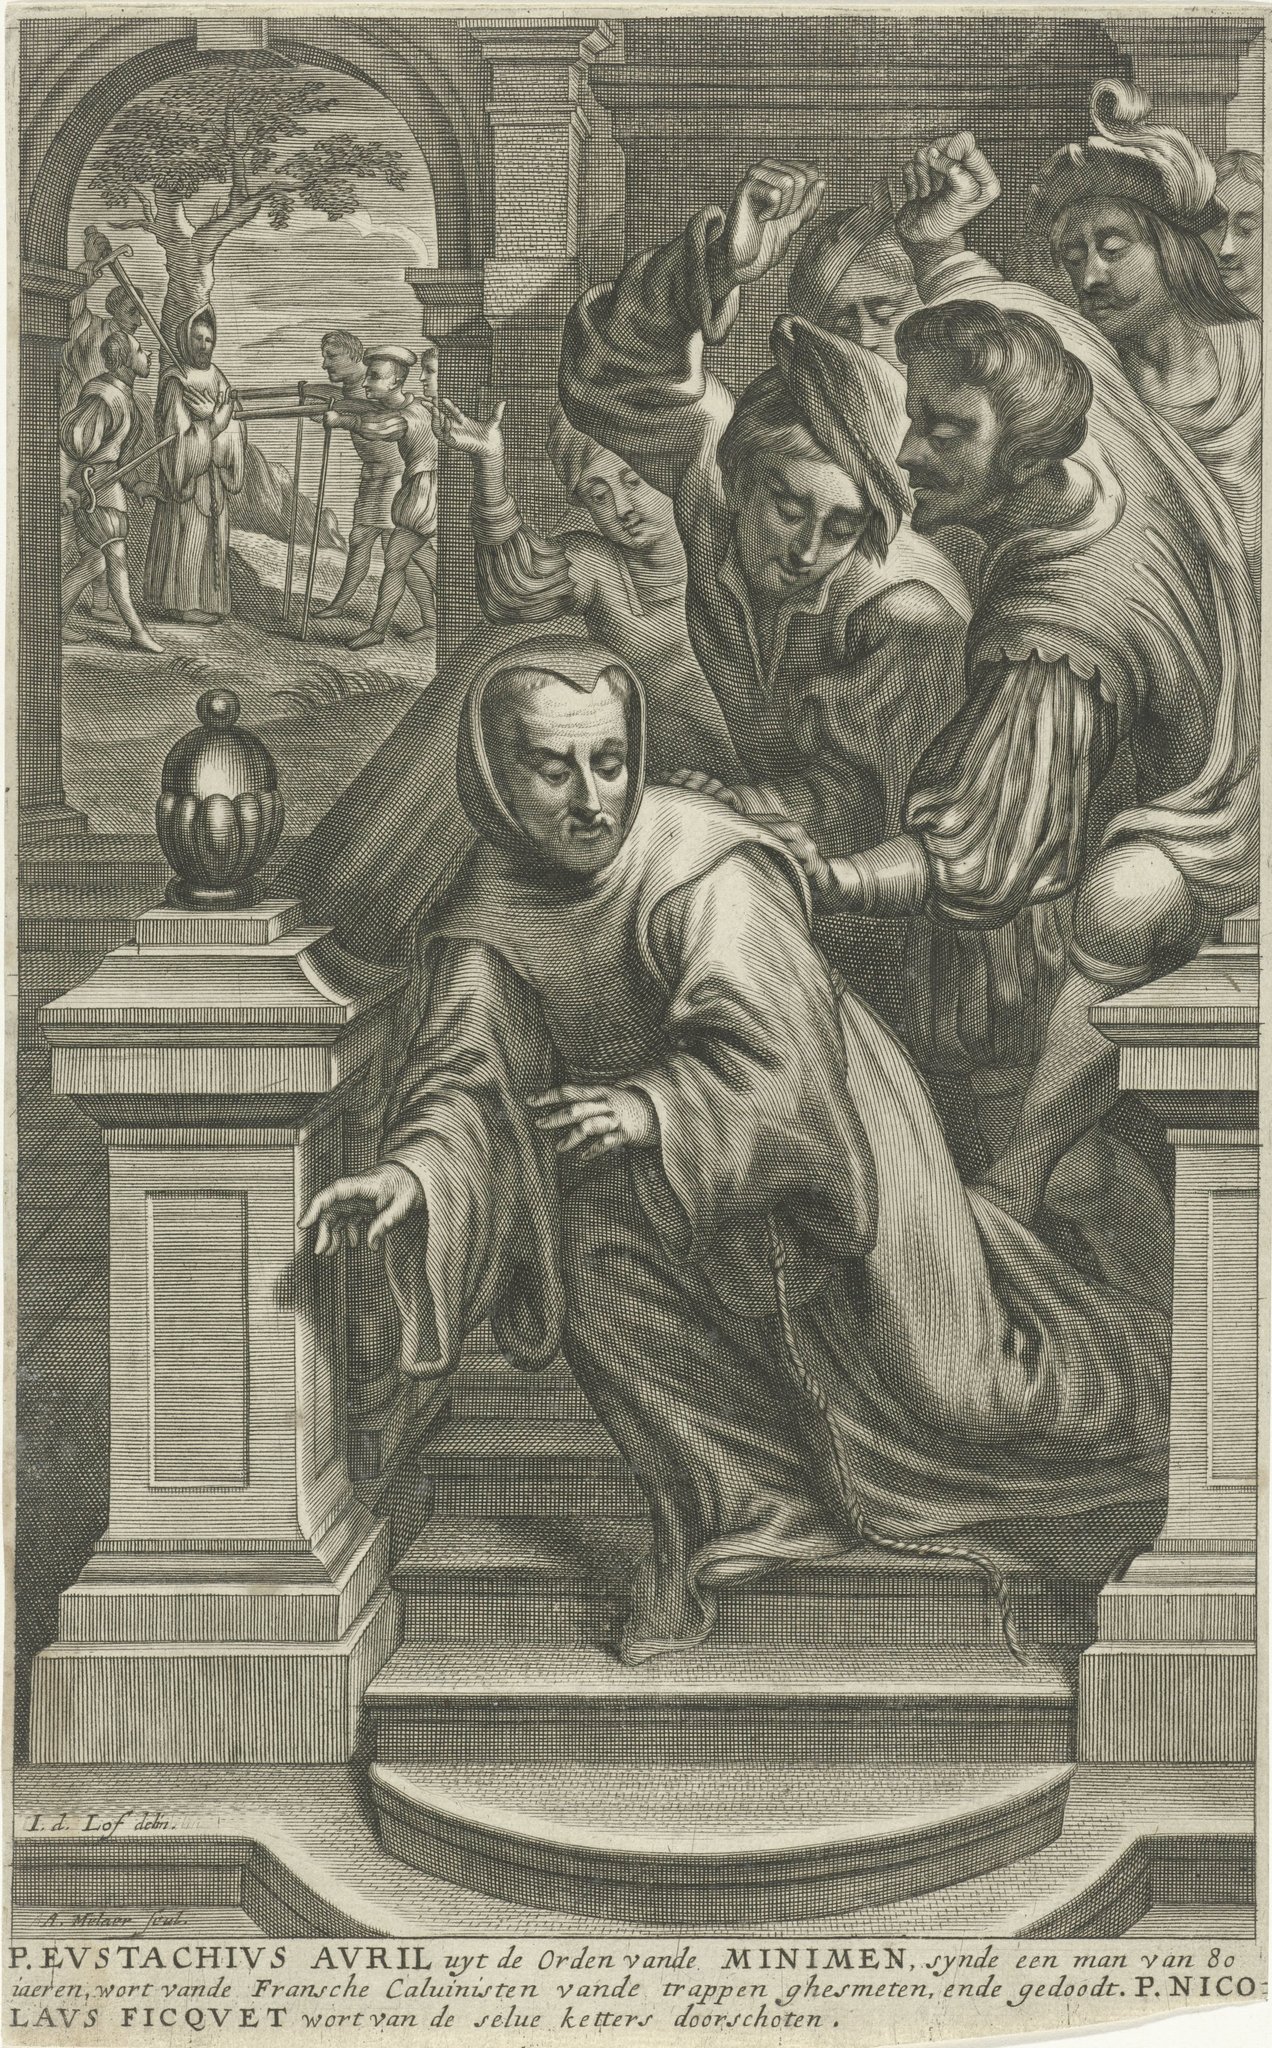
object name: print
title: Eustachius Avril door calvinisten van de trap geworpen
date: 1645-1668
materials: paper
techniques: engraving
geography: antwerp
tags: dying from the effects of a fall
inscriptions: collector's mark: Lugt 2228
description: De monnik Eustachius Avril van Plessis wordt door calvinisten van de trap geworpen, waarna hij overlijdt. Door een poort links Nicolas Ficquet, die wordt beschoten en doorstoken door calvinisten.